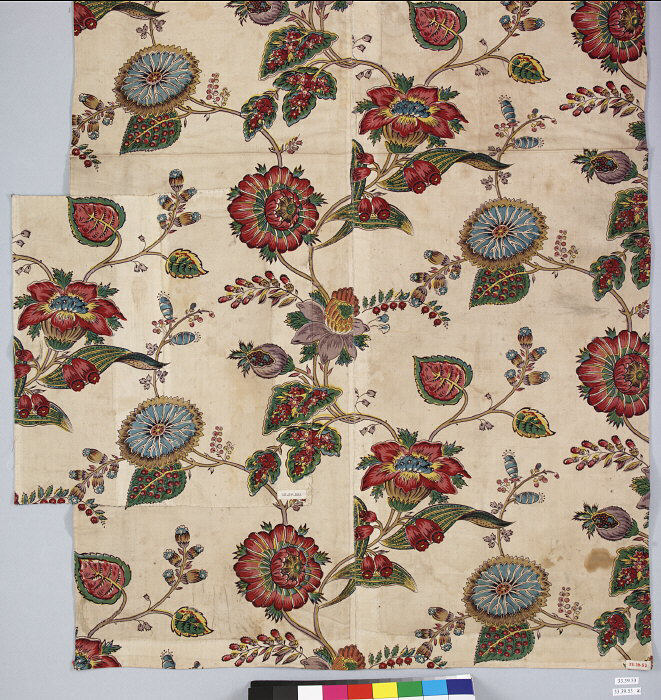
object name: fragment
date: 1767-1800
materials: cotton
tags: flowers,leaves